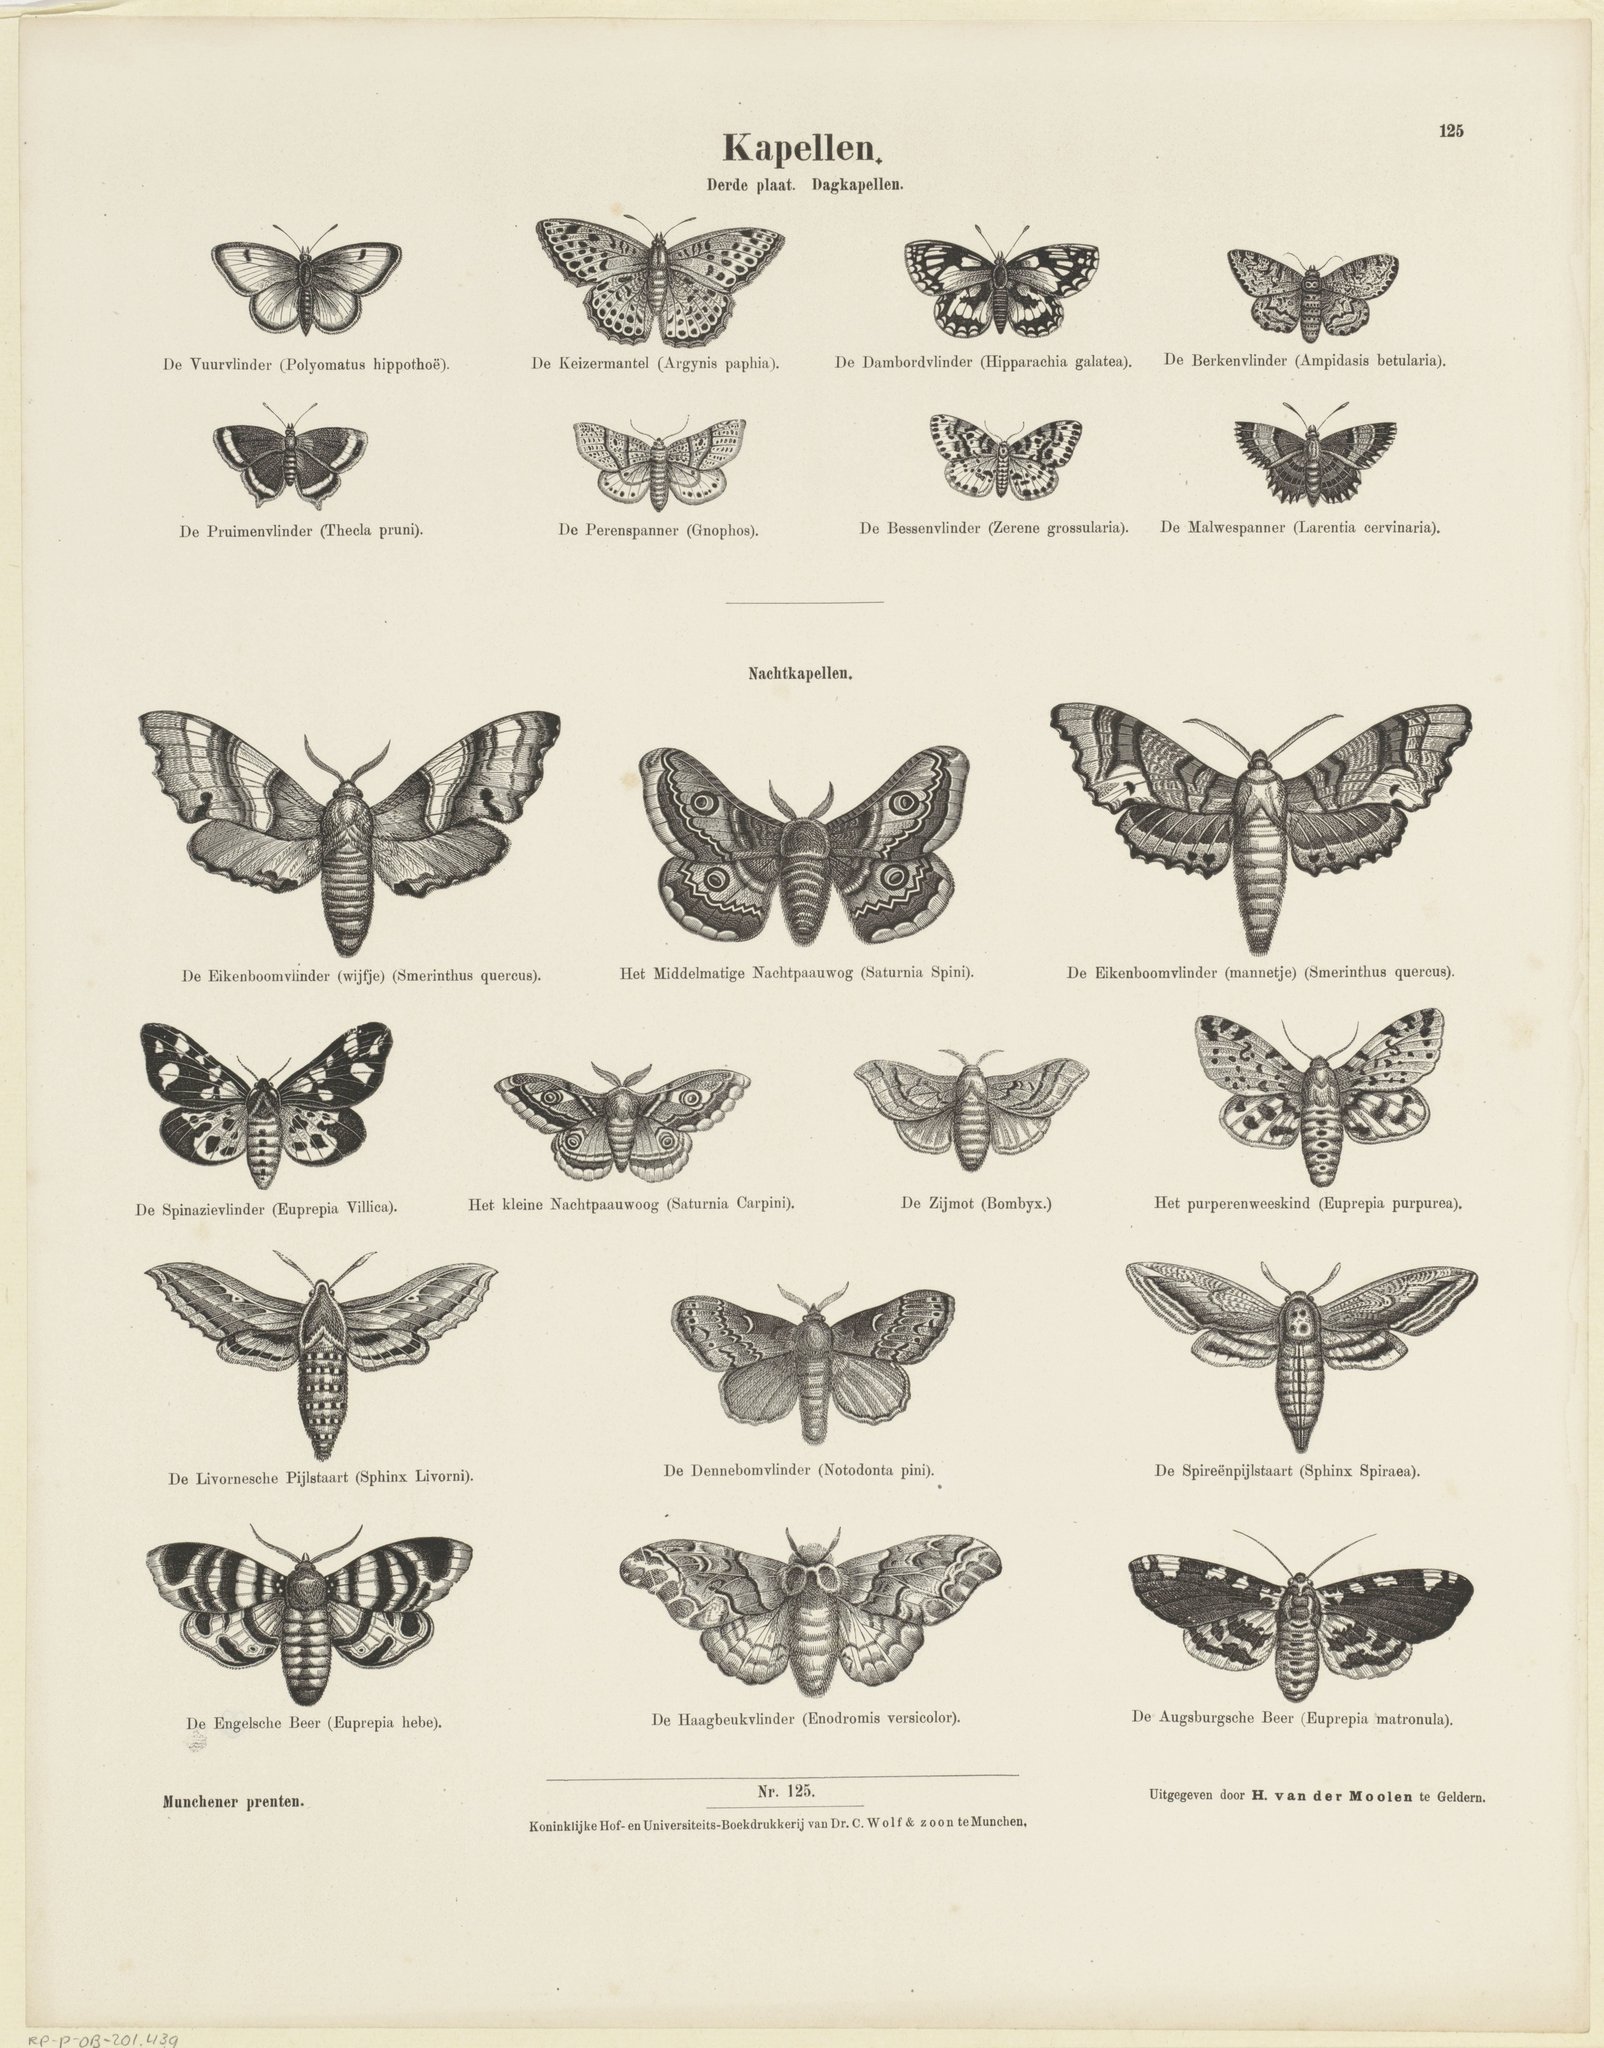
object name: popular print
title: Munchener platen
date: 1843-1920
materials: paper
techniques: letterpress printing, engraving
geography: munich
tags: insects: butterfly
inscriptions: collector's mark: Lugt 2760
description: Blad met 21 voorstellingen van verschillende vlinders. Onder elke vlinder een naam in het Nederlands en in het Latijn. Genummerd midden onder: Nro. 125. Genummerd rechtsboven: 125.